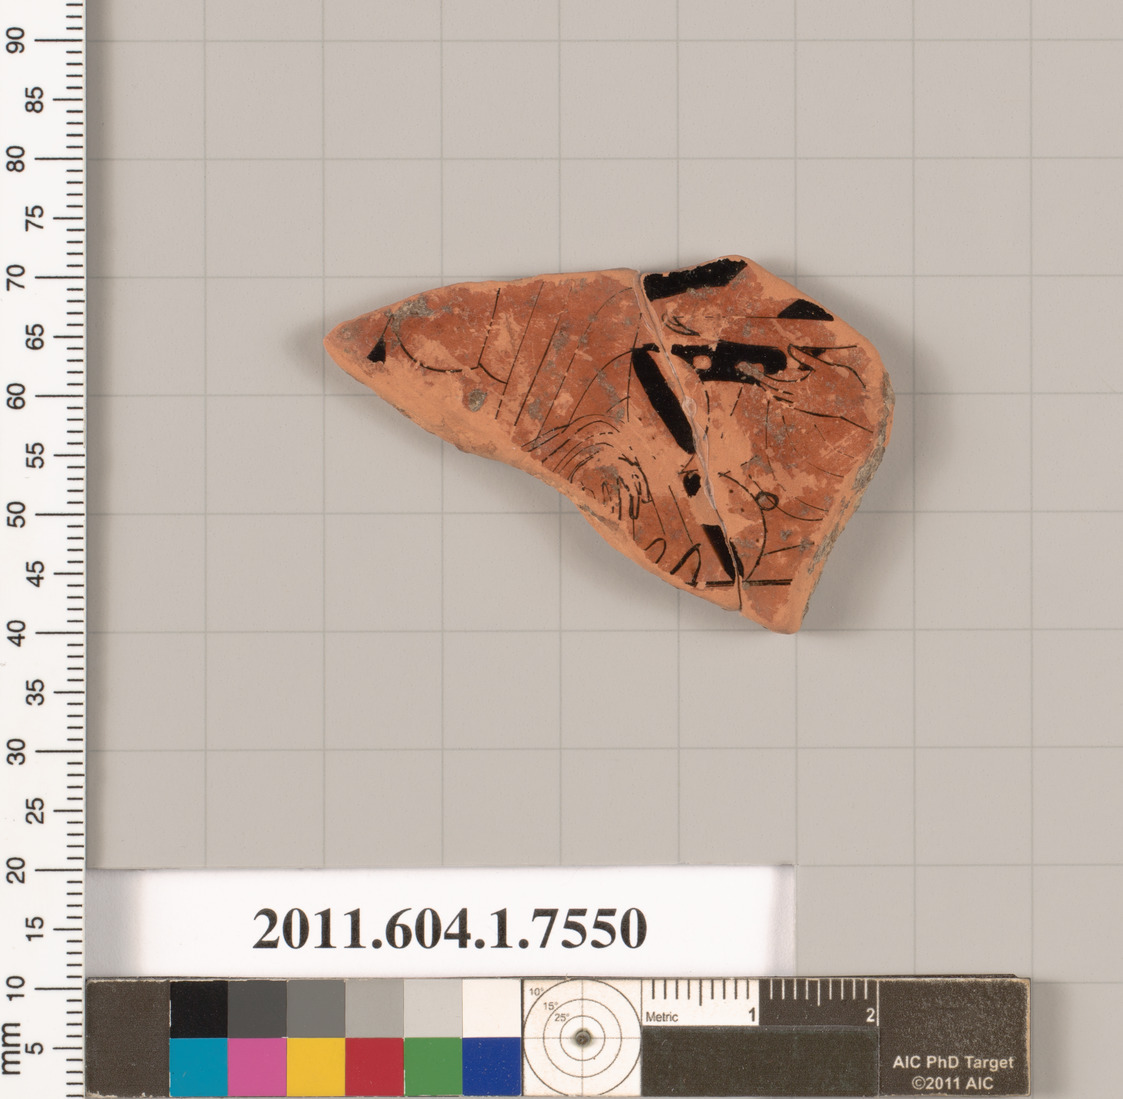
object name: kylix fragment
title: Terracotta fragment of a kylix (drinking cup)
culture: greek, attic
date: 460-450 BCE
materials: terracotta